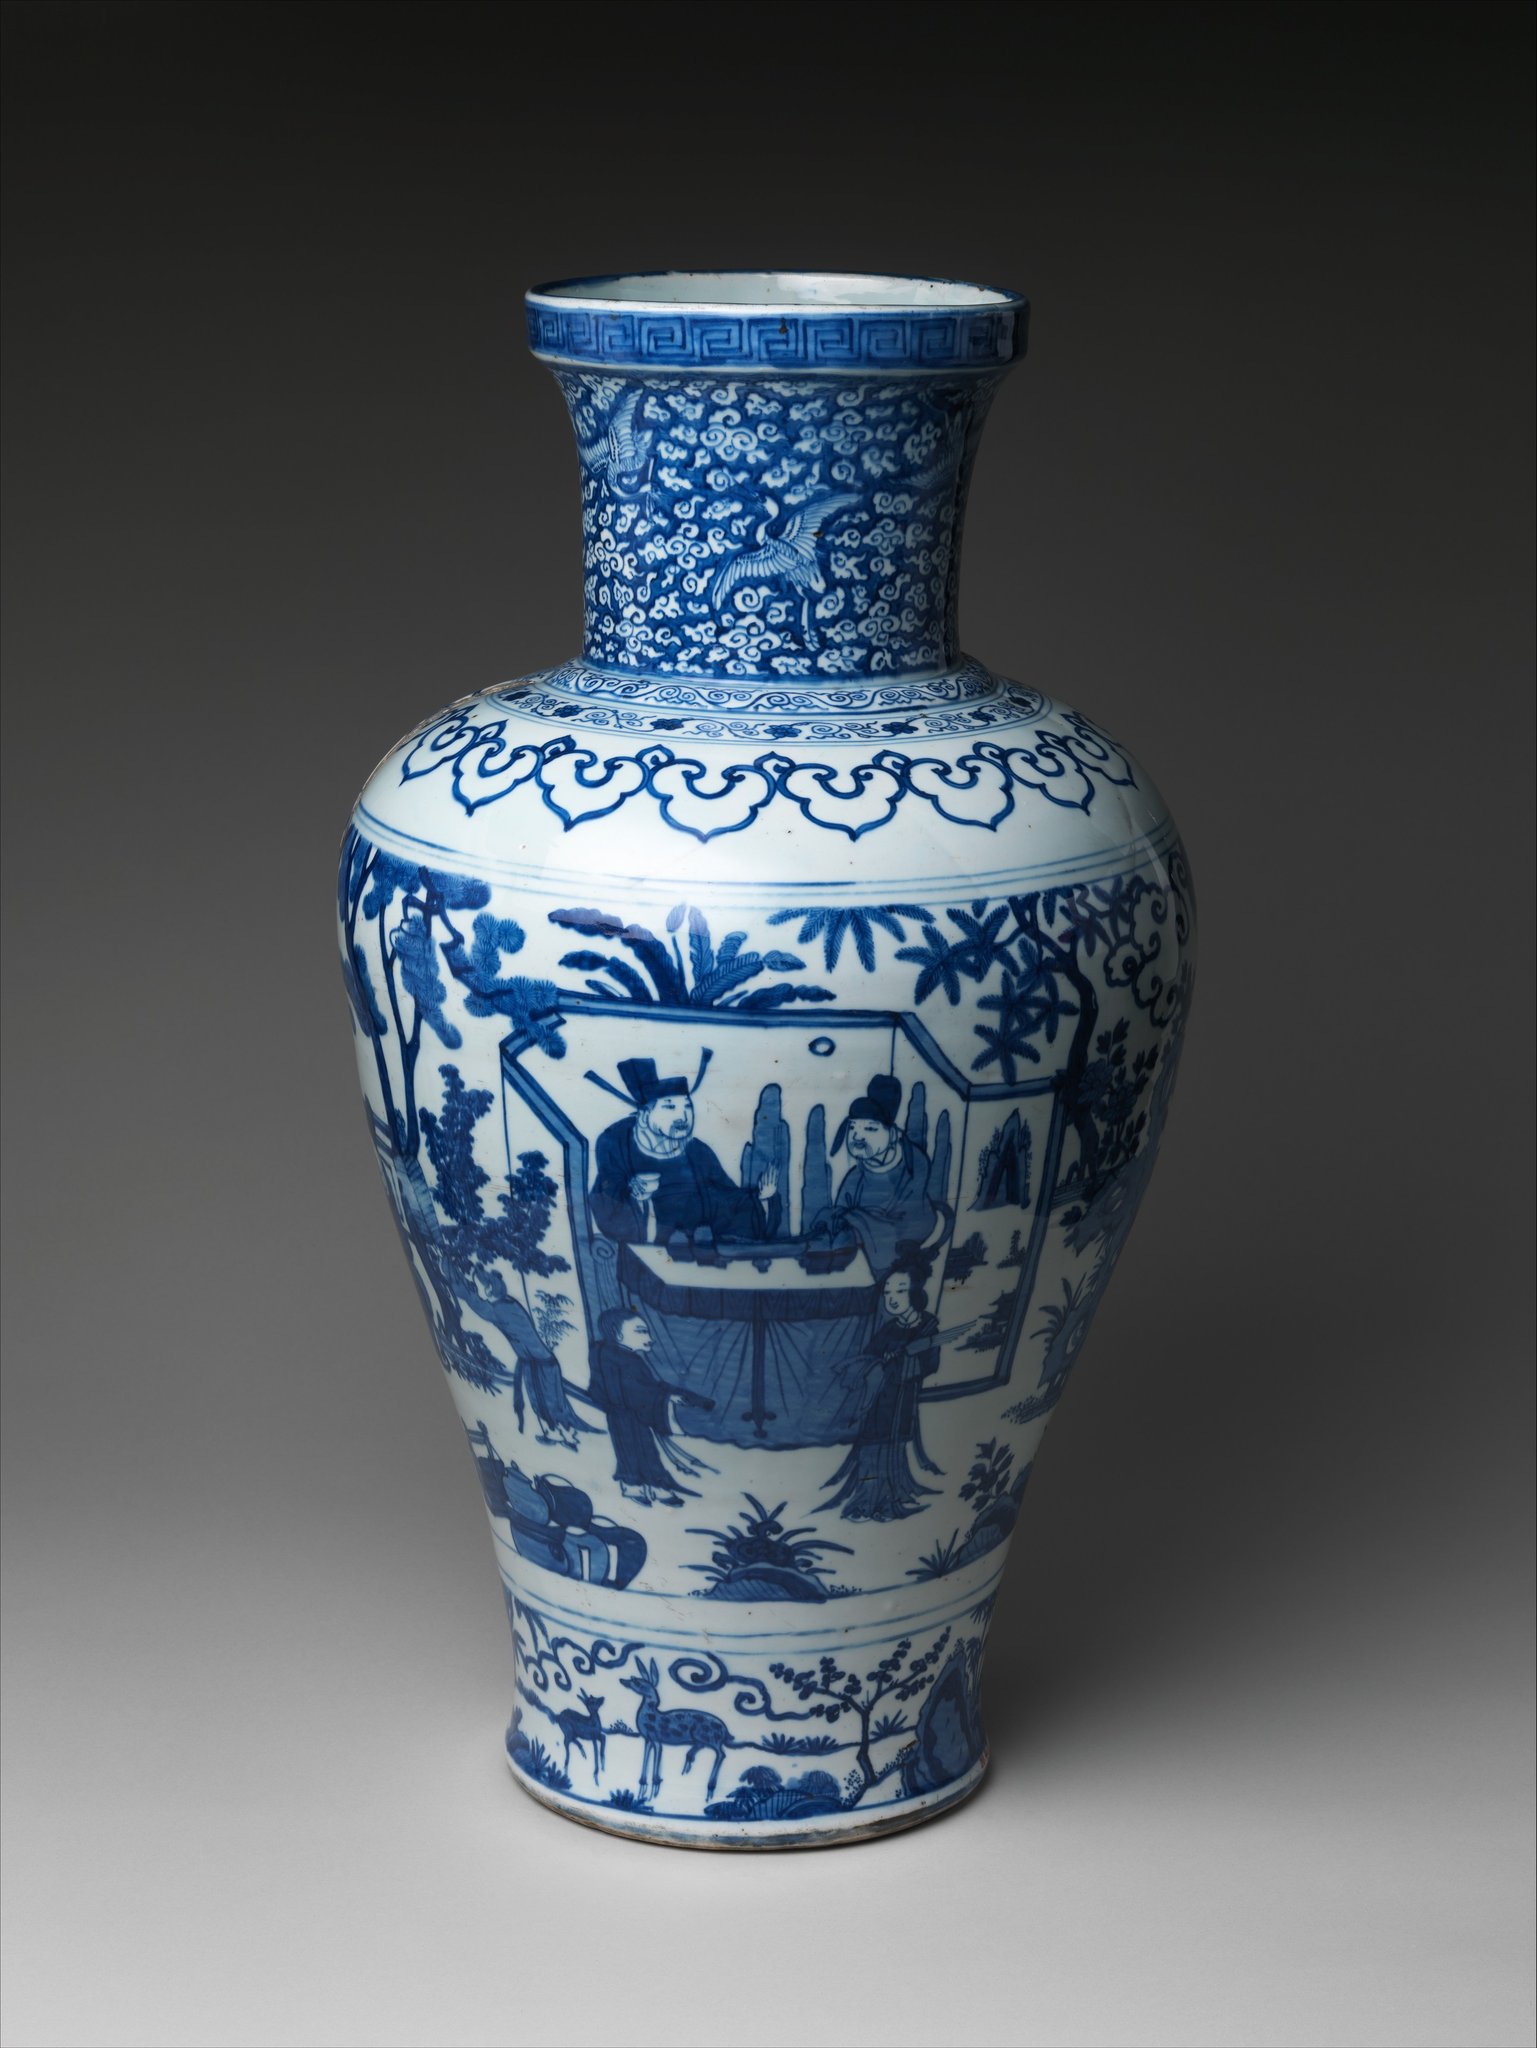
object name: vase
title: Vase with Poet Zhou Dunyi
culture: chinese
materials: cobalt, glaze, porcelain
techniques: painting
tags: men